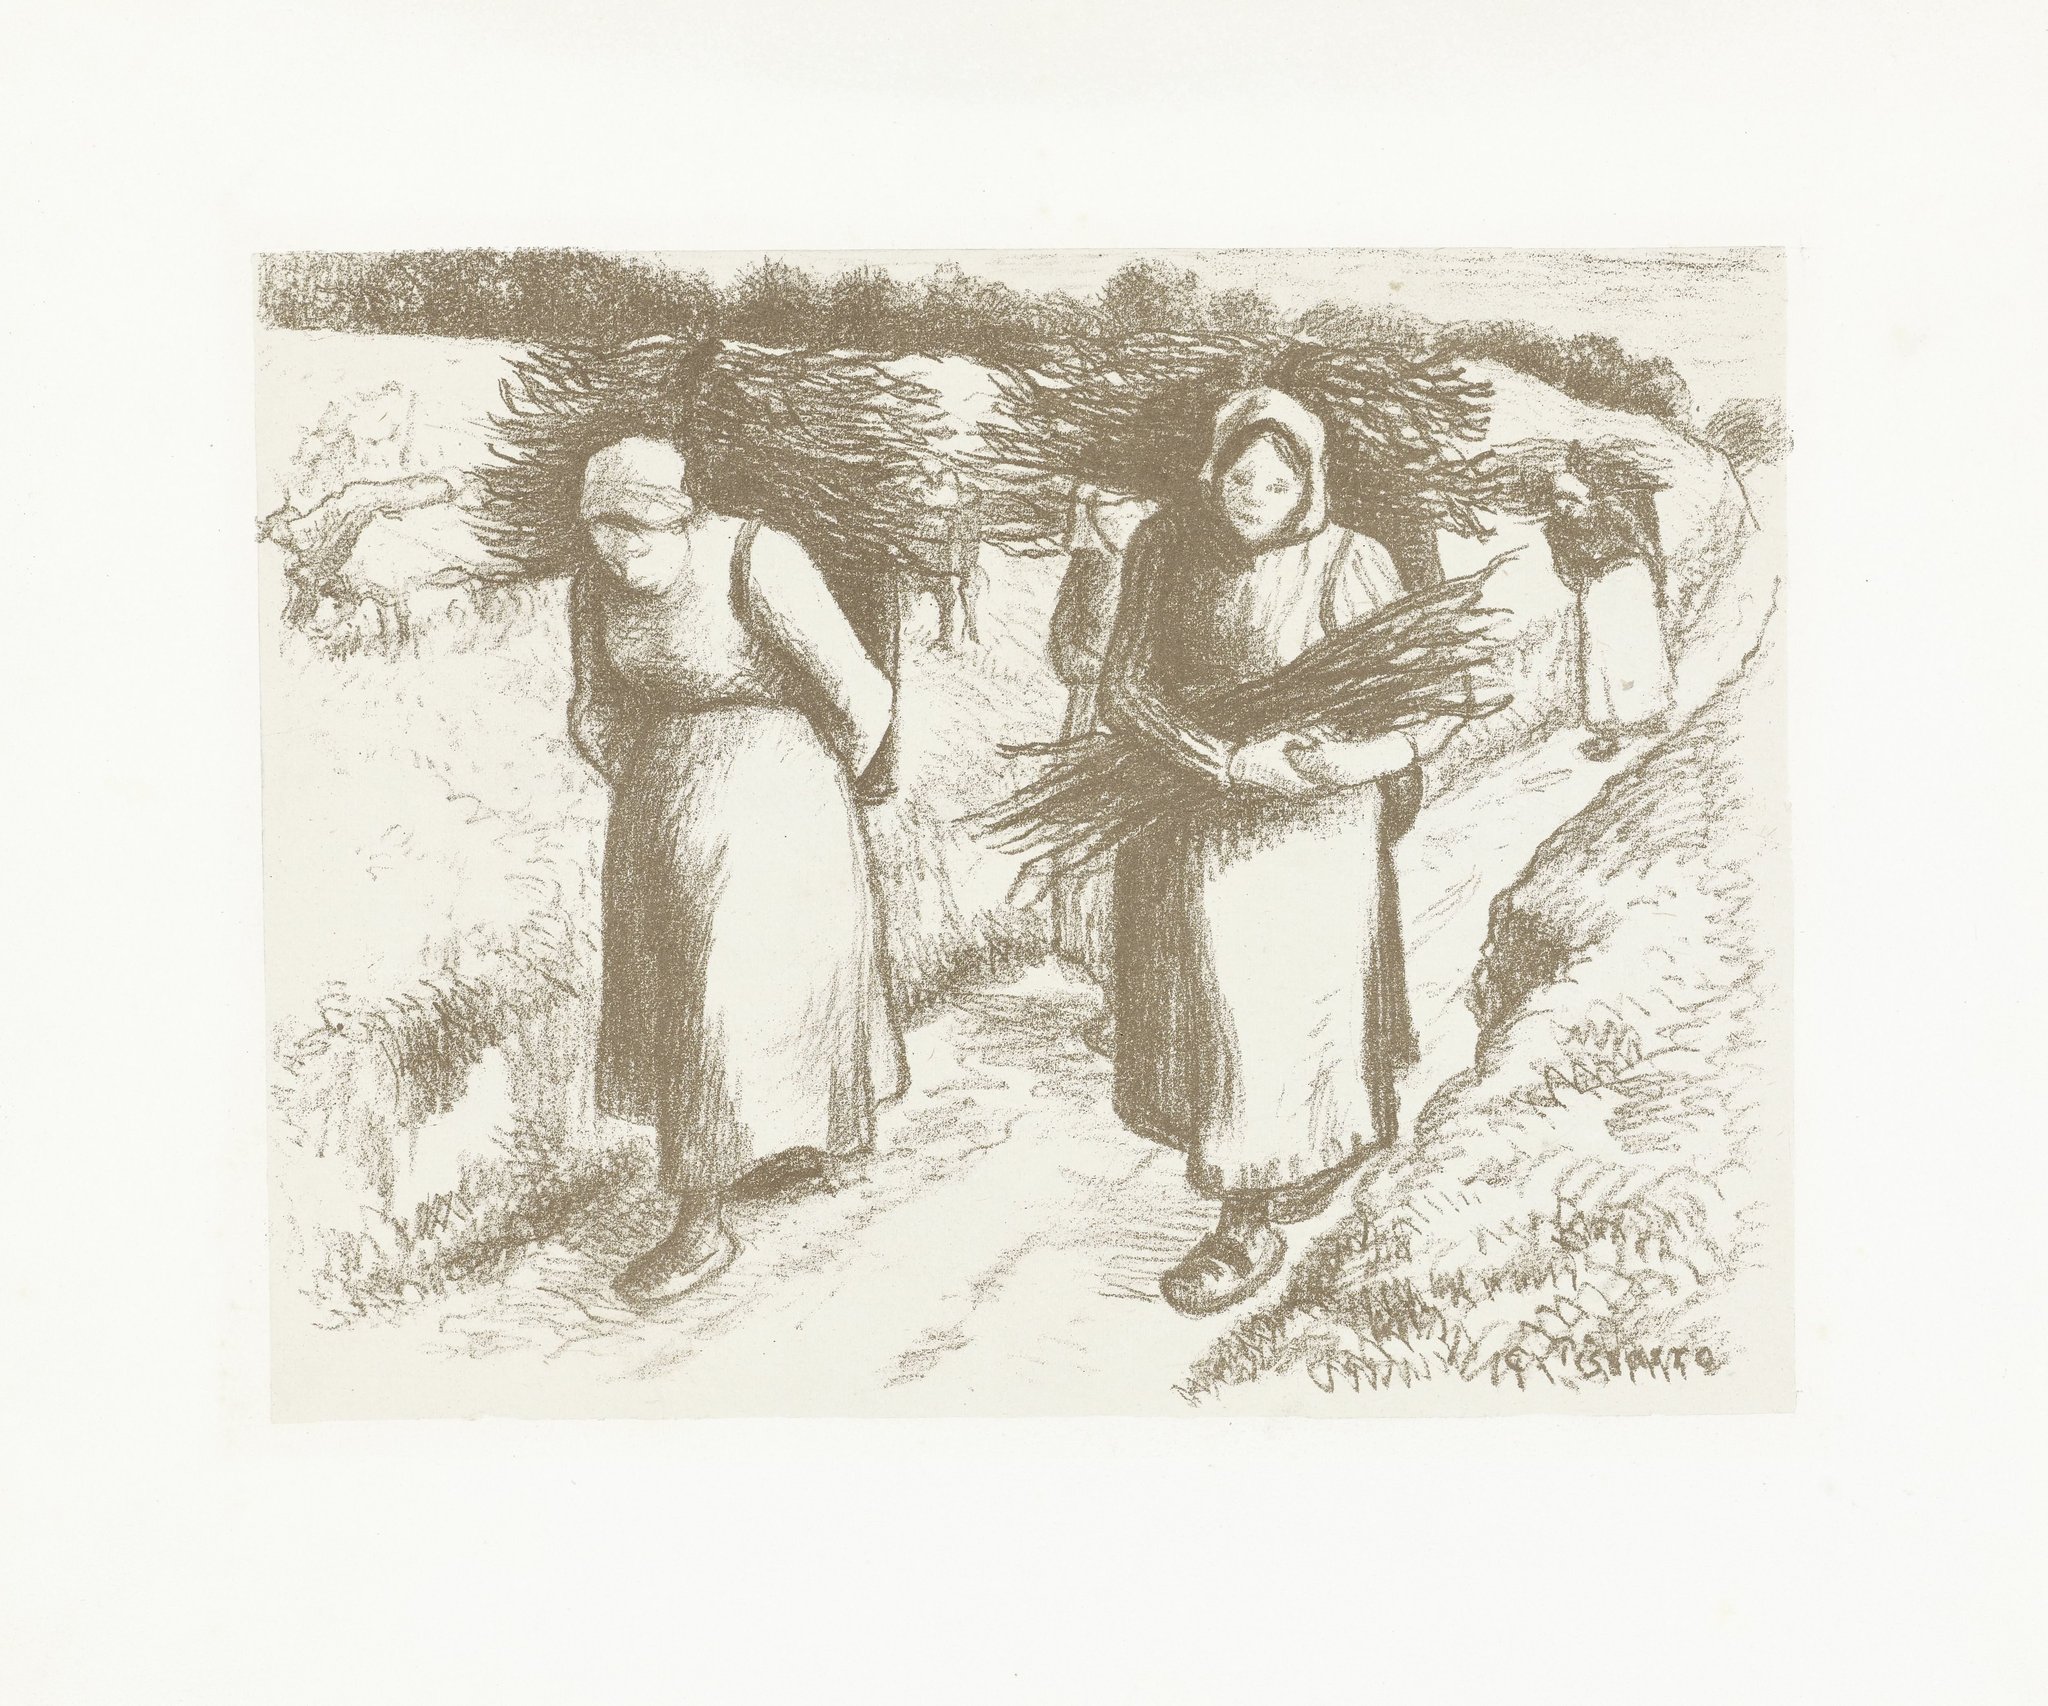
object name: print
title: Vrouwen dragen takkenbossen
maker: camille jacob pissarro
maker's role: draughtsman, print maker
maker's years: 1830-1903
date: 1896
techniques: printmaking, printing, lithograph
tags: woodgathering, woodgatherer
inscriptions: collector's mark: Lugt 2228, collector's mark: Lugt 2760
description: Vier vrouwen hebben hout gesprokkeld en lopen met manden vol takkenbossen op hun rug op een weg langs weiden.